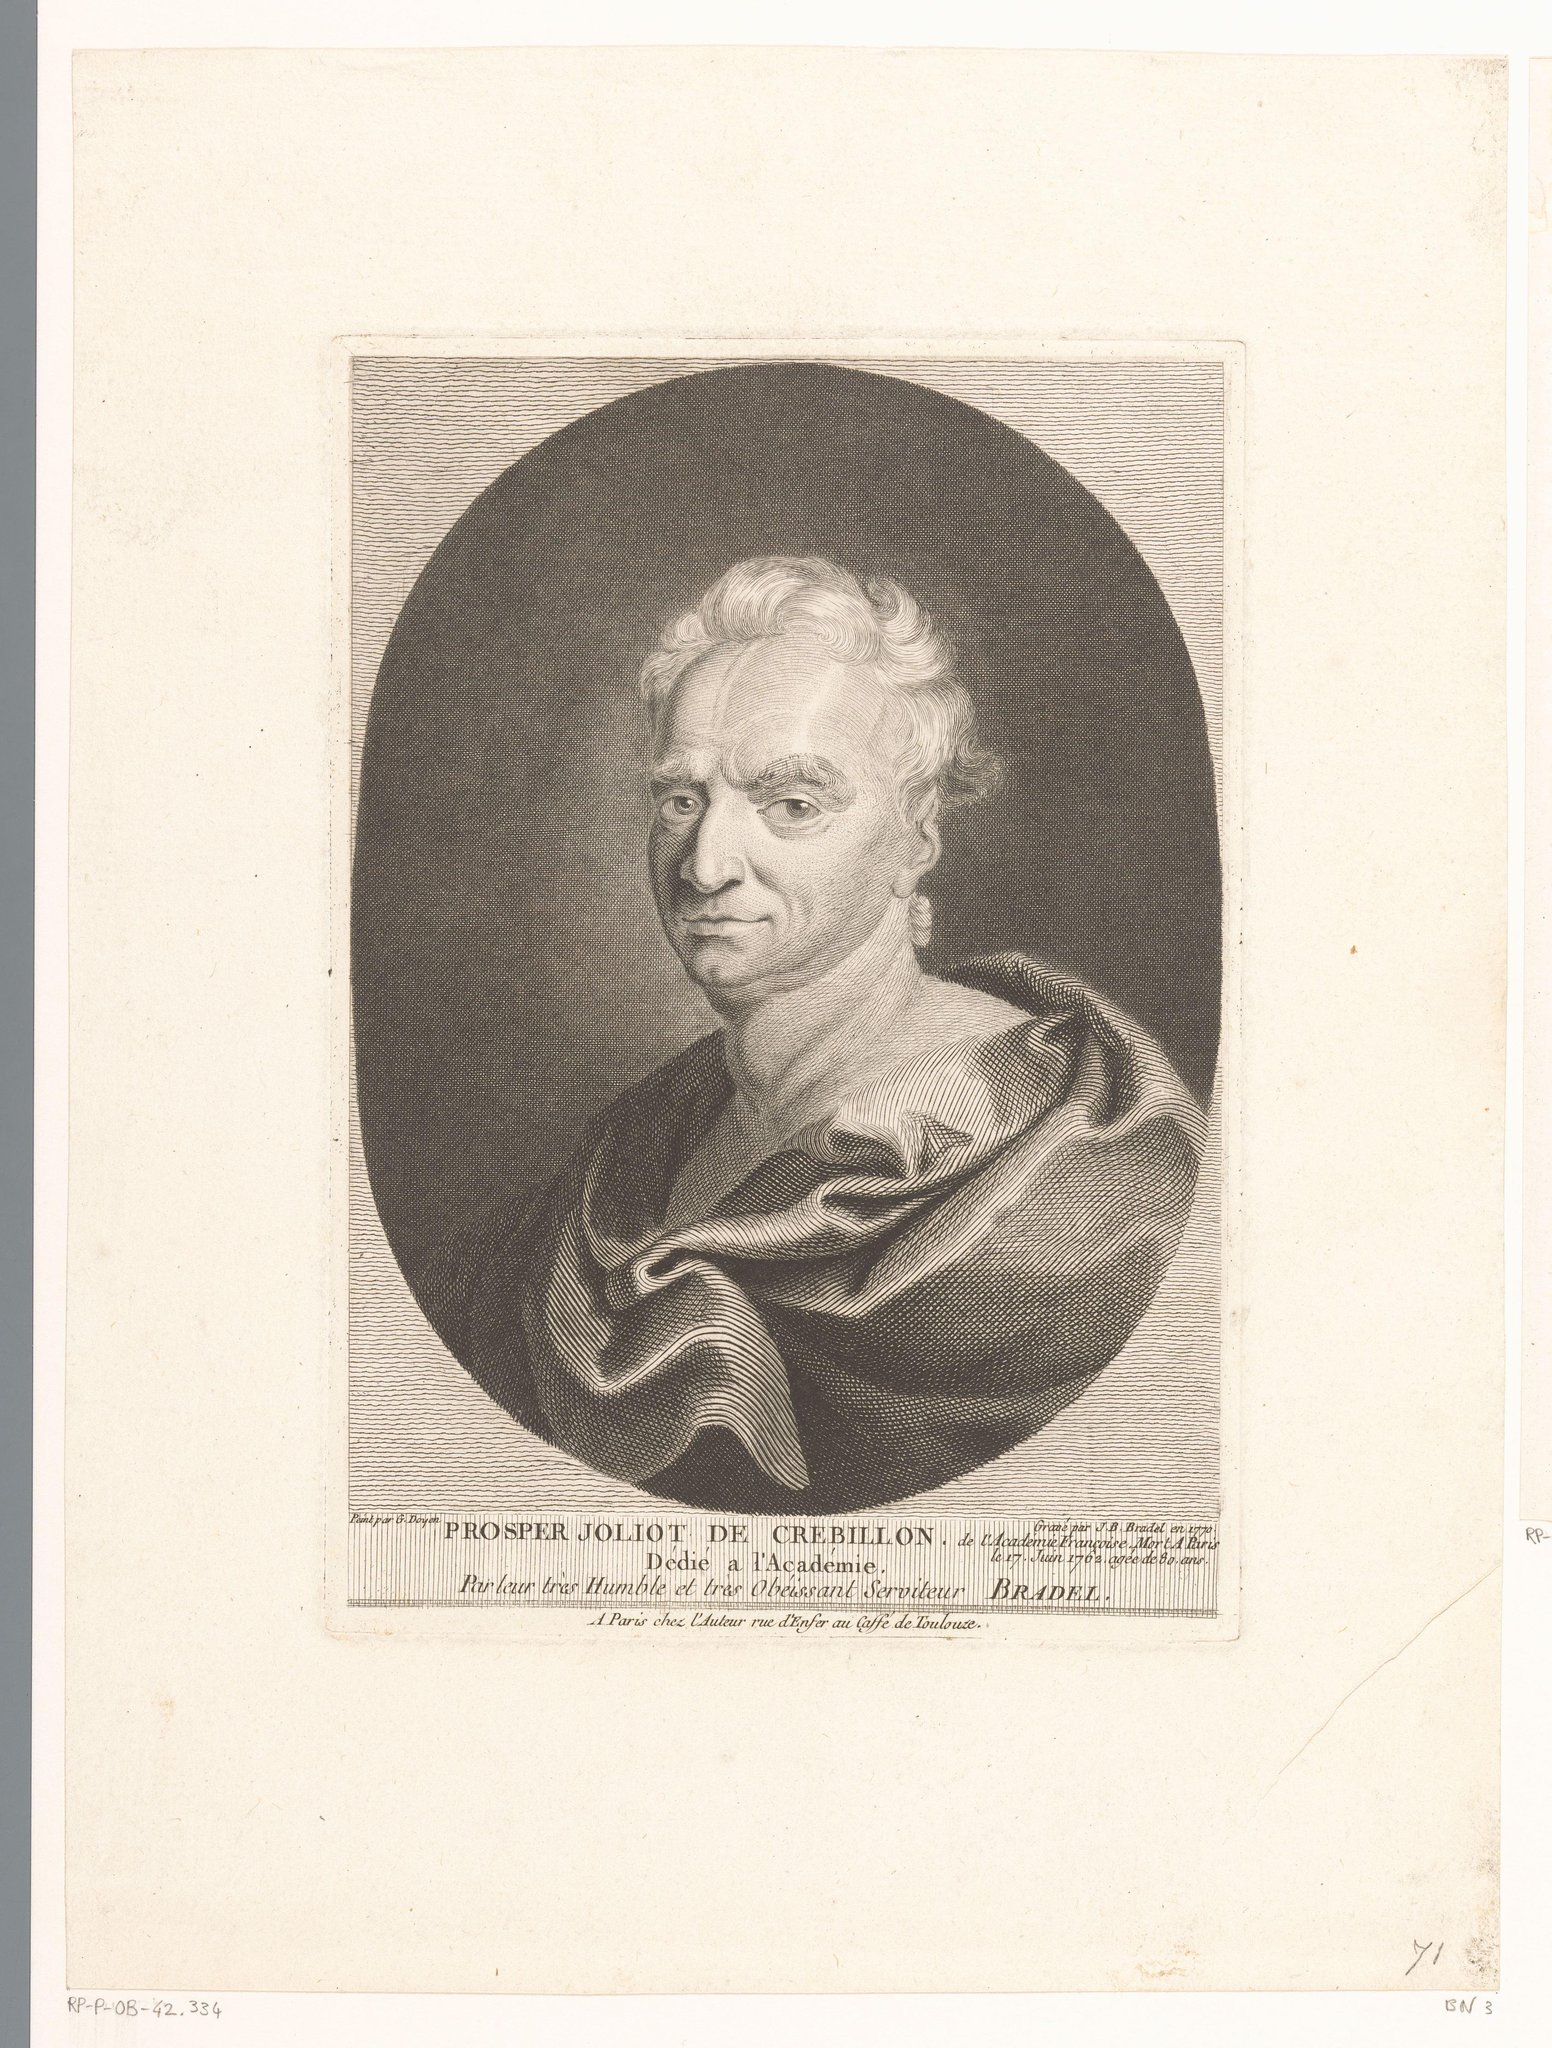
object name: print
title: Portret van Prosper Jolyot de Crébillon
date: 1770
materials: paper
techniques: engraving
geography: paris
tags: historical persons, portrait of a writer, writer, poet, author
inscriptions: collector's mark: Lugt 240